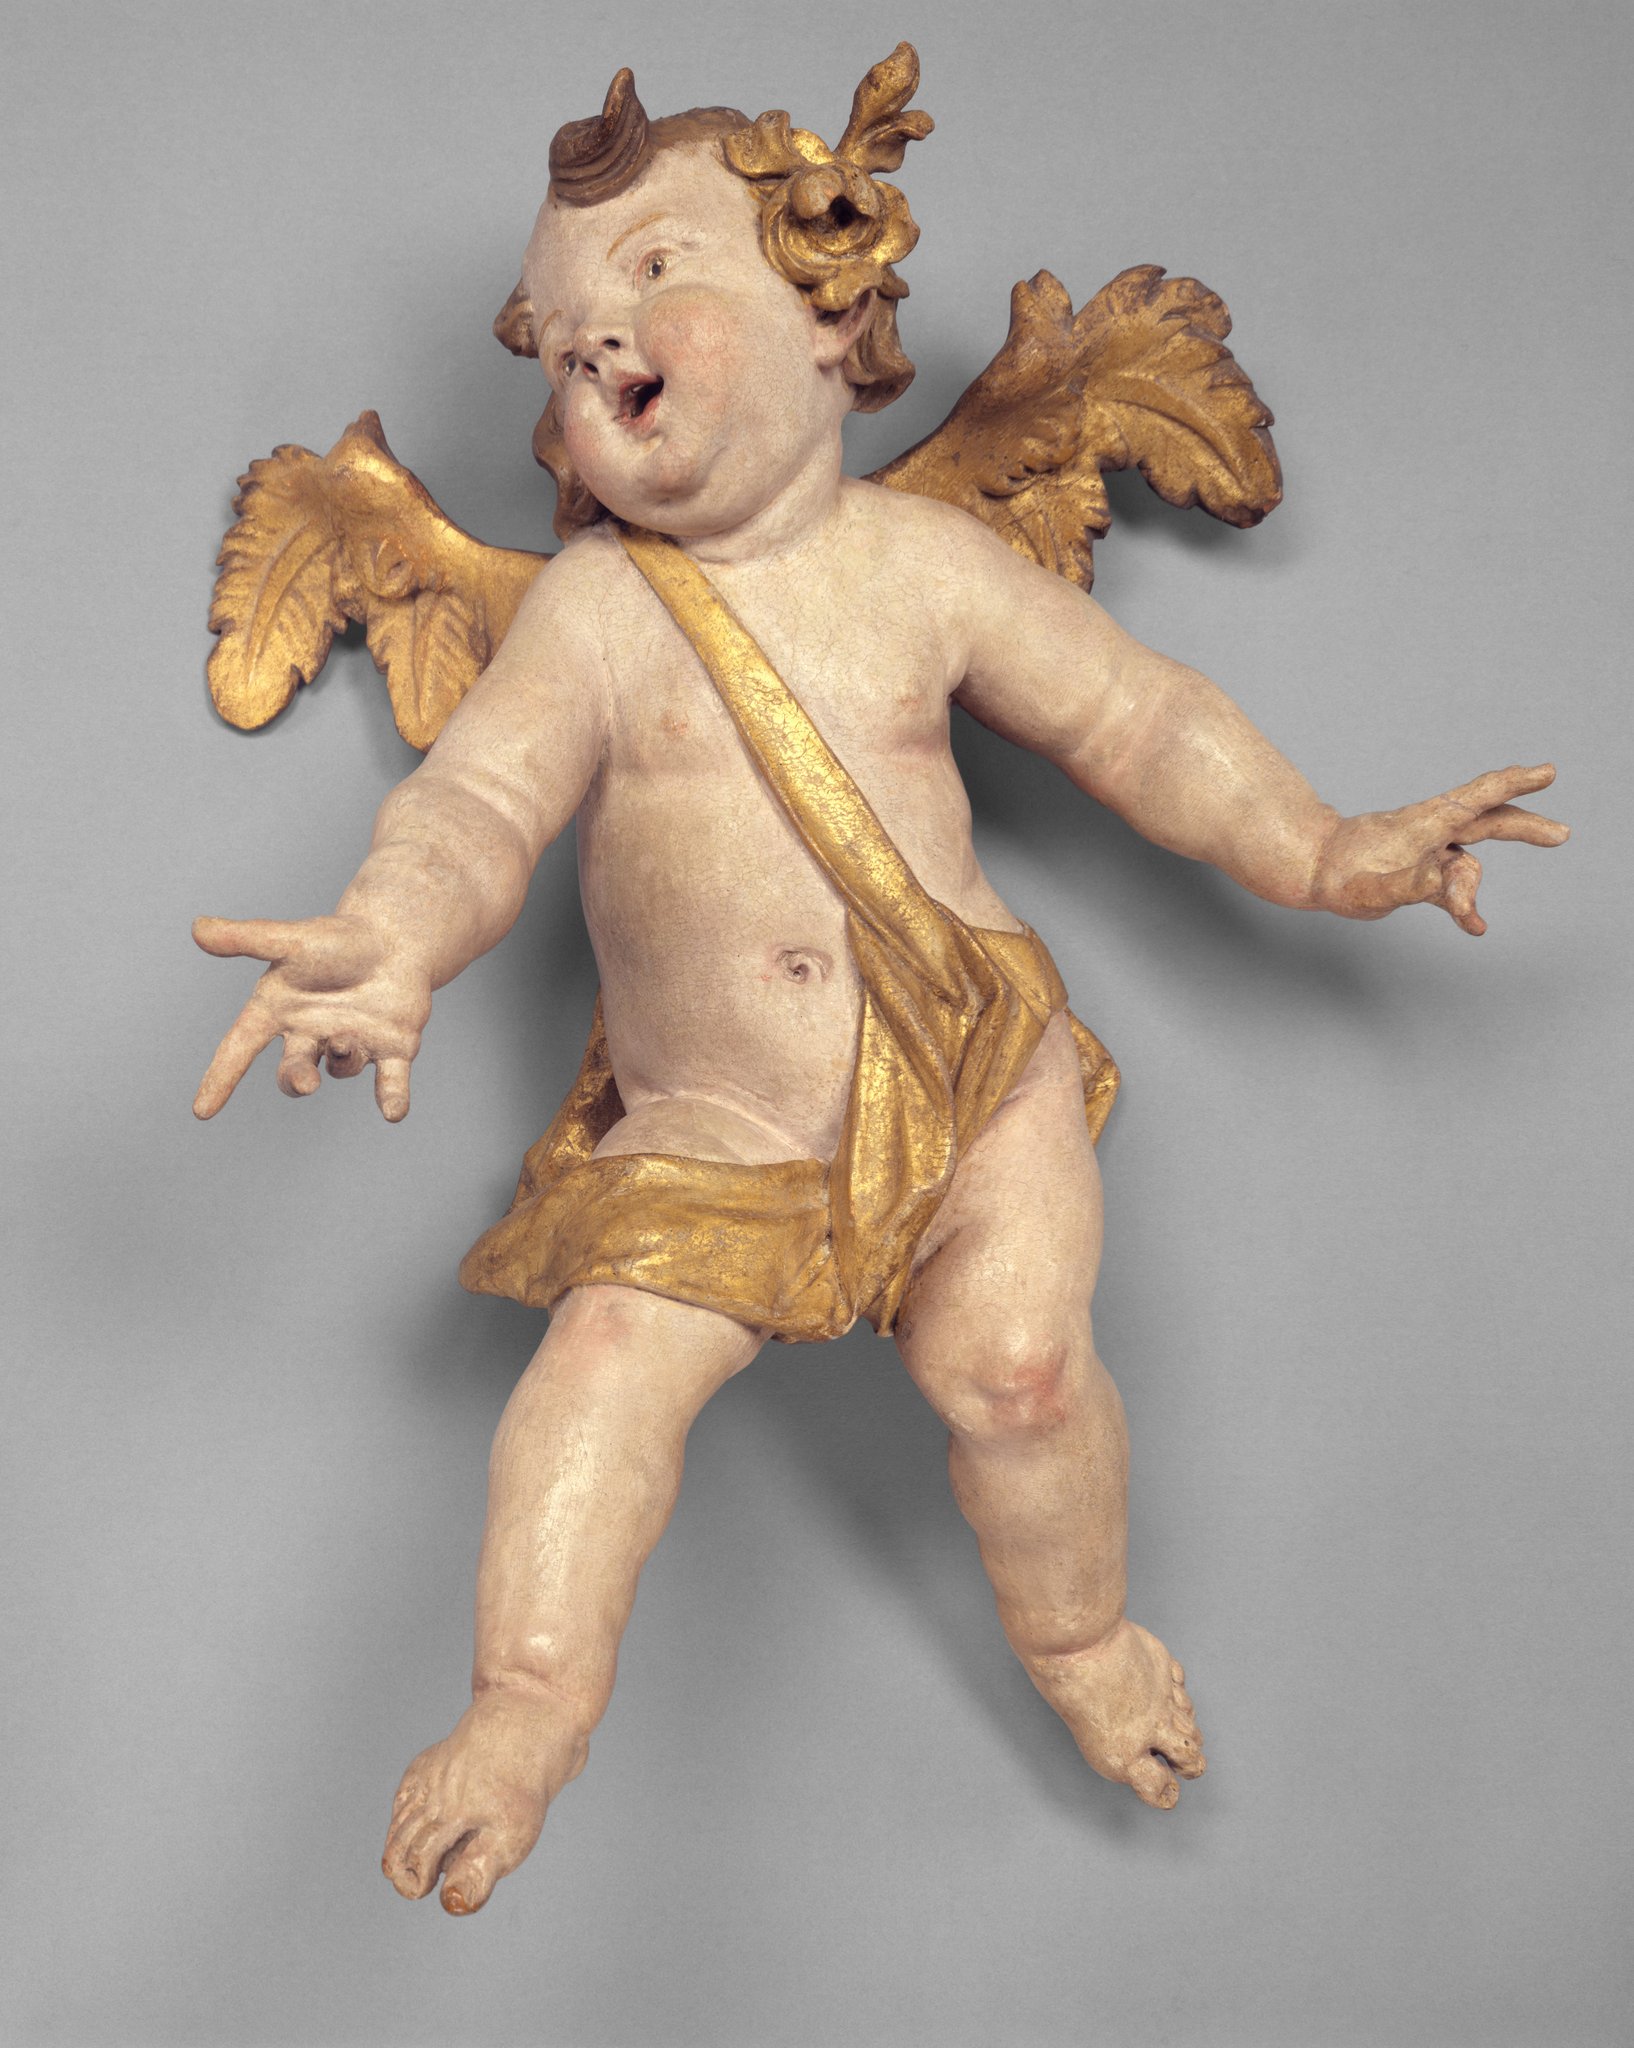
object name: angel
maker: christian jorhan the elder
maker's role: artist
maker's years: 1727-1804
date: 1734-1766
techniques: gilding, polychromy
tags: angels